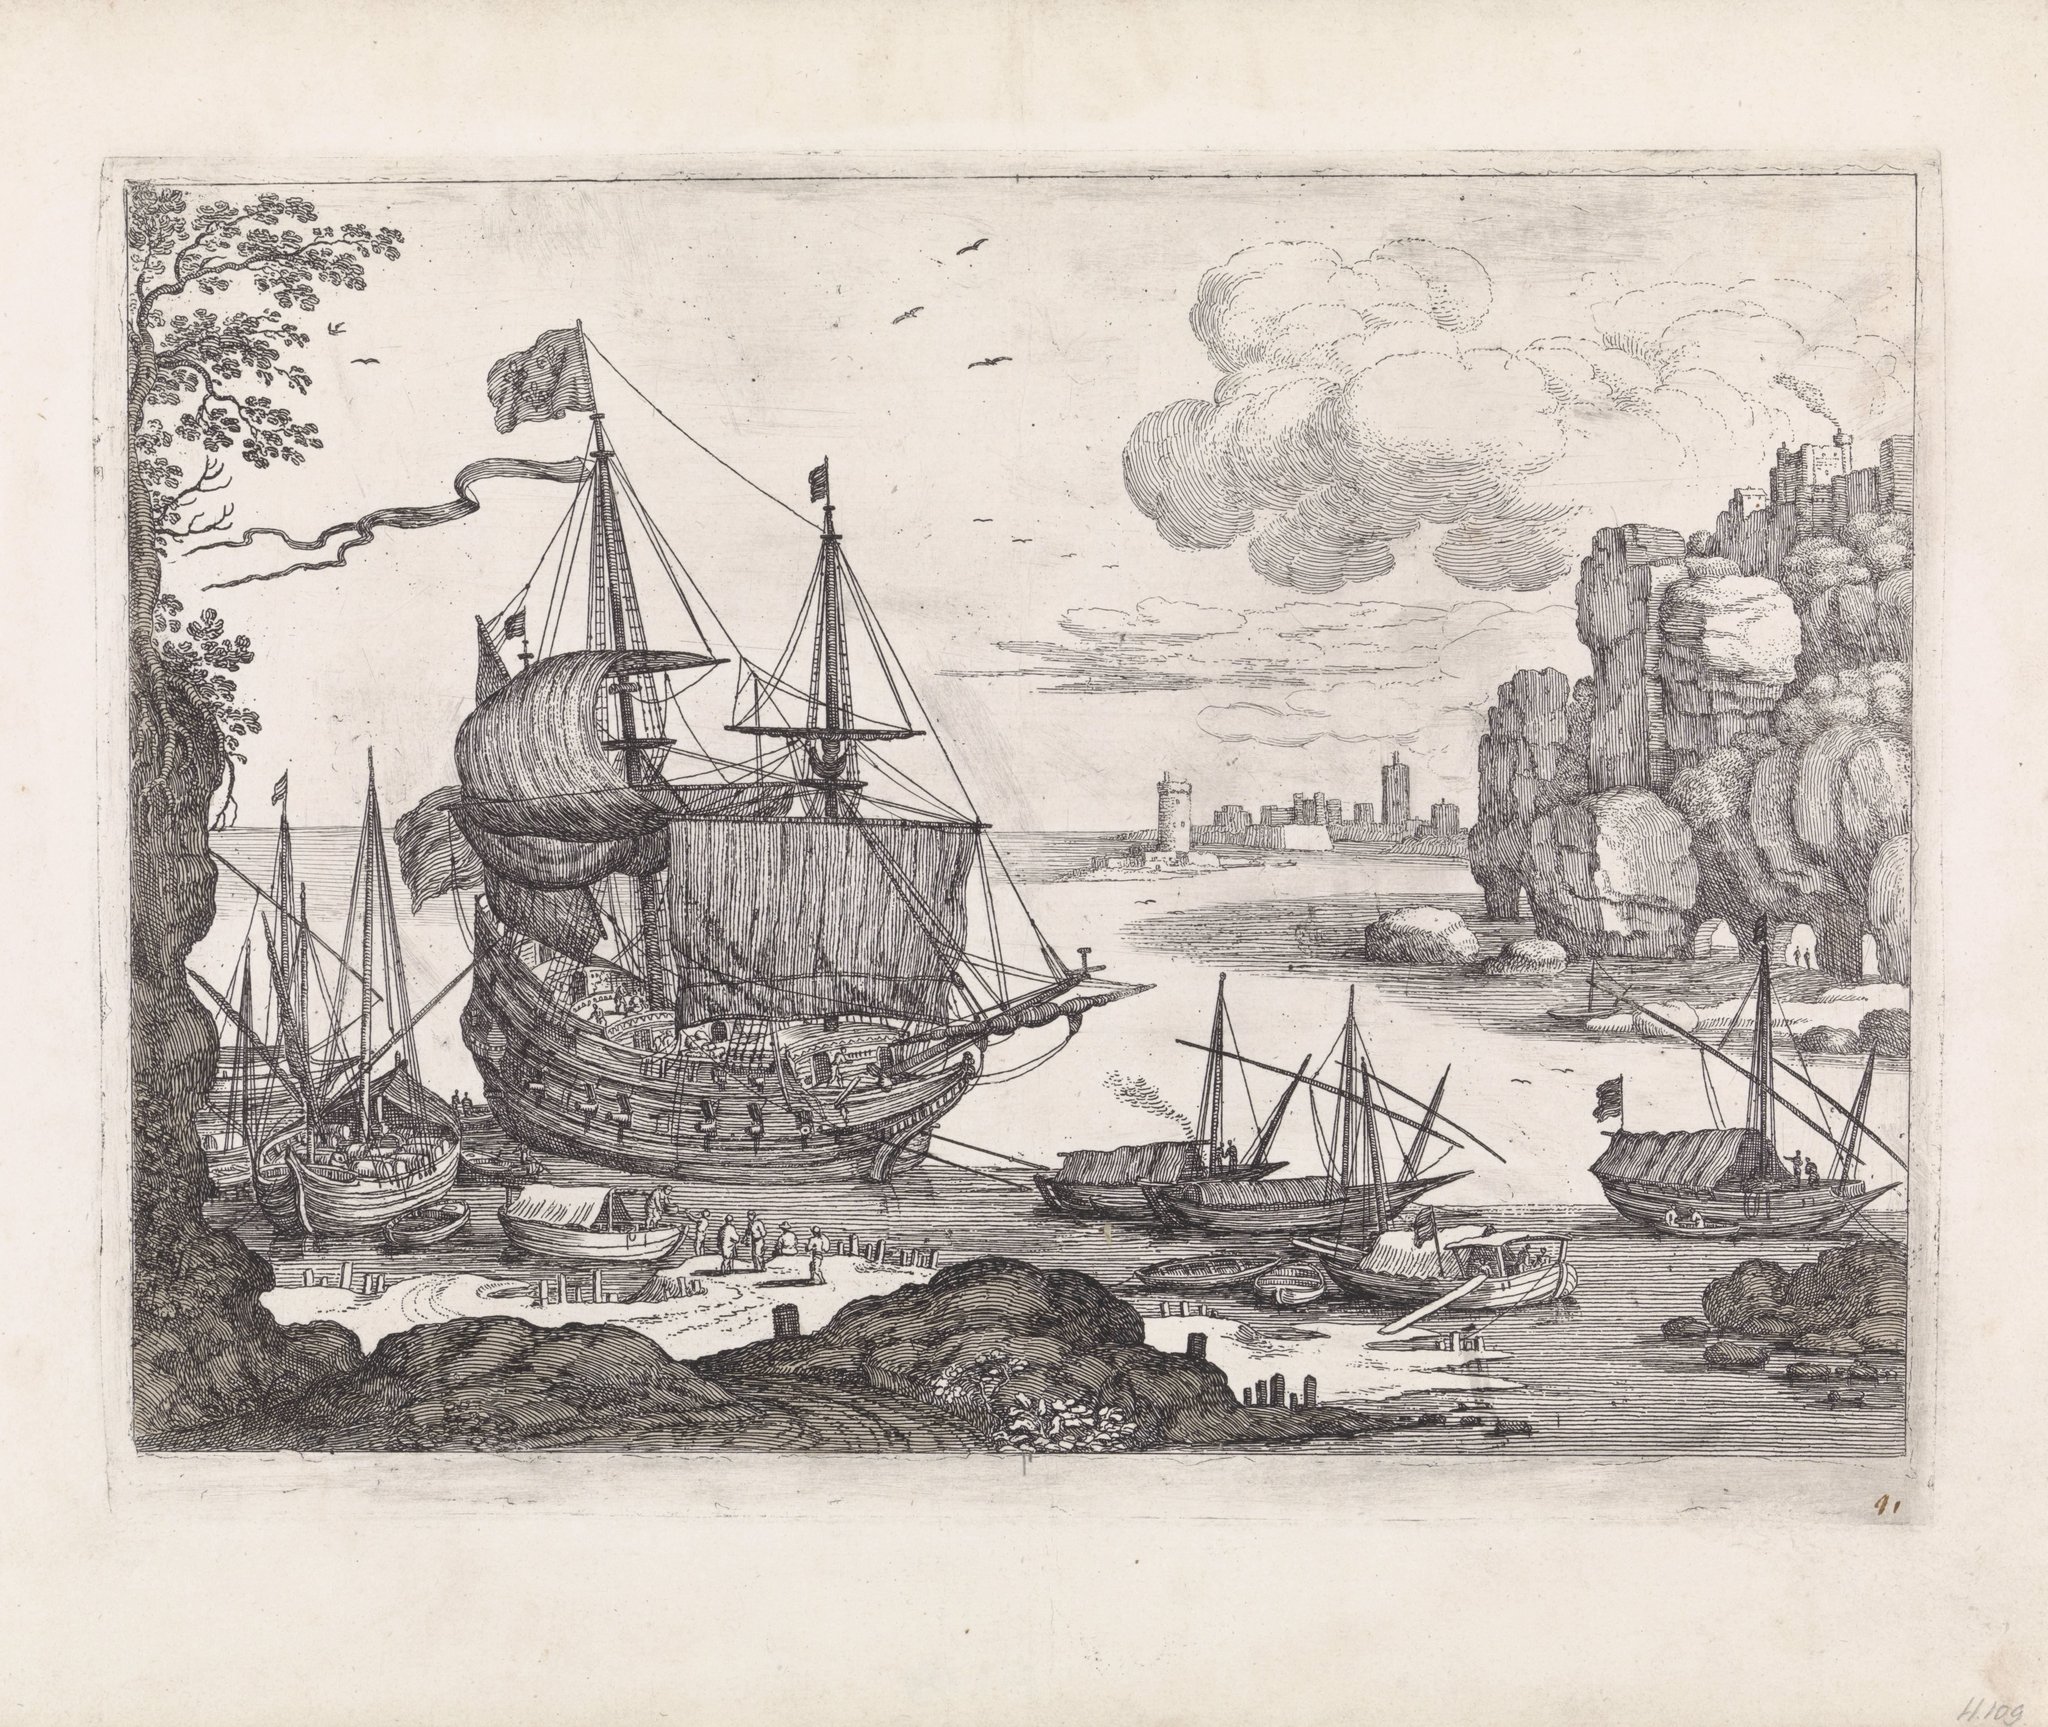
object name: print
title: Schepen in een haven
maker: guilliam van nieulandt (ii)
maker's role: draughtsman, print maker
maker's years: 1584-1635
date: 1594-1635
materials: paper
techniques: brush, etching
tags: harbour, sailing-ship, sailing-boat, landscapes in the temperate zone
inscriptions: collector's mark: Lugt 2228, inscription: ‘41’, collector's mark: Lugt 2760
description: In een haven liggen verschillende zeilschepen en één groot zeilschip, dat een vlag voert met drie Franse lelies. Prent uit een serie Italiaanse landschappen.